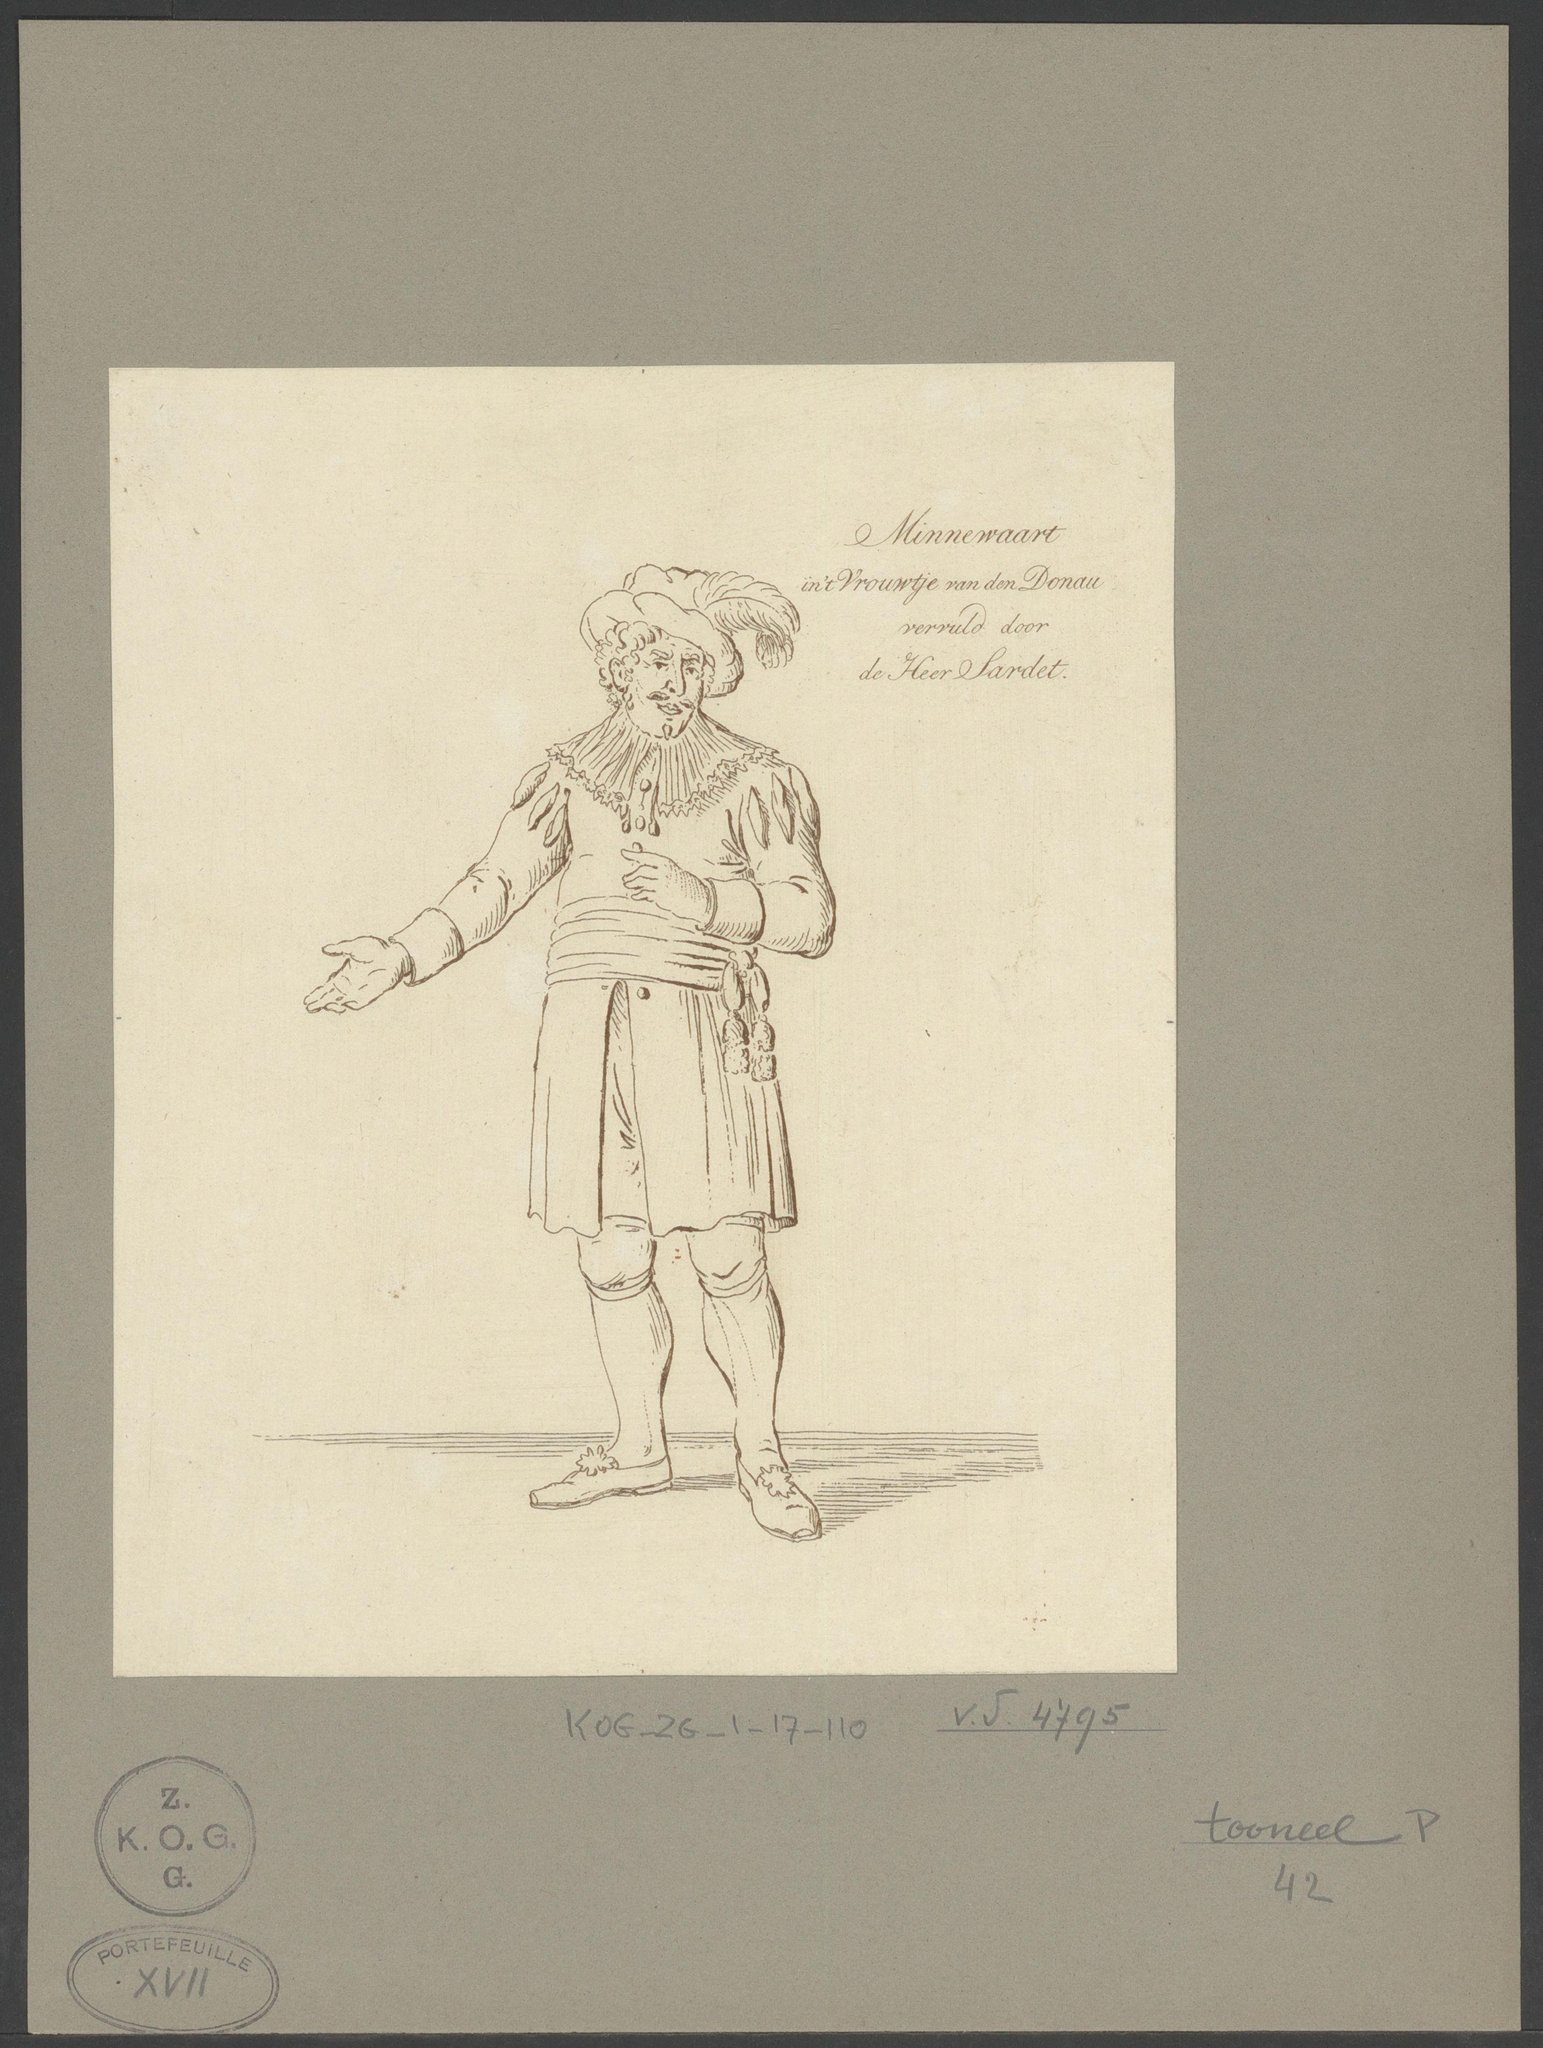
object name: print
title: Minnewaart in 't Vrouwtje van den Donau vervuld door de Heer Sardet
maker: johannes jelgerhuis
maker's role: draughtsman, painter, print maker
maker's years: 1770-1836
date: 1805-1836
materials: paper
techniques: etching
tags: dirk sardet, actor (on the stage)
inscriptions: collector's mark: Lugt 1641, stamp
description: De acteur de heer Sardet als Minnewaart, gekleed in fantasiekostuum. Prent uit een serie van tien met Nederlandse acteurs en actrices in verschillende rollen. Onderwerpsrubrieken binnen de Atlas Zeden en Gewoonten: Tooneel, Portretten van toneelspelers.